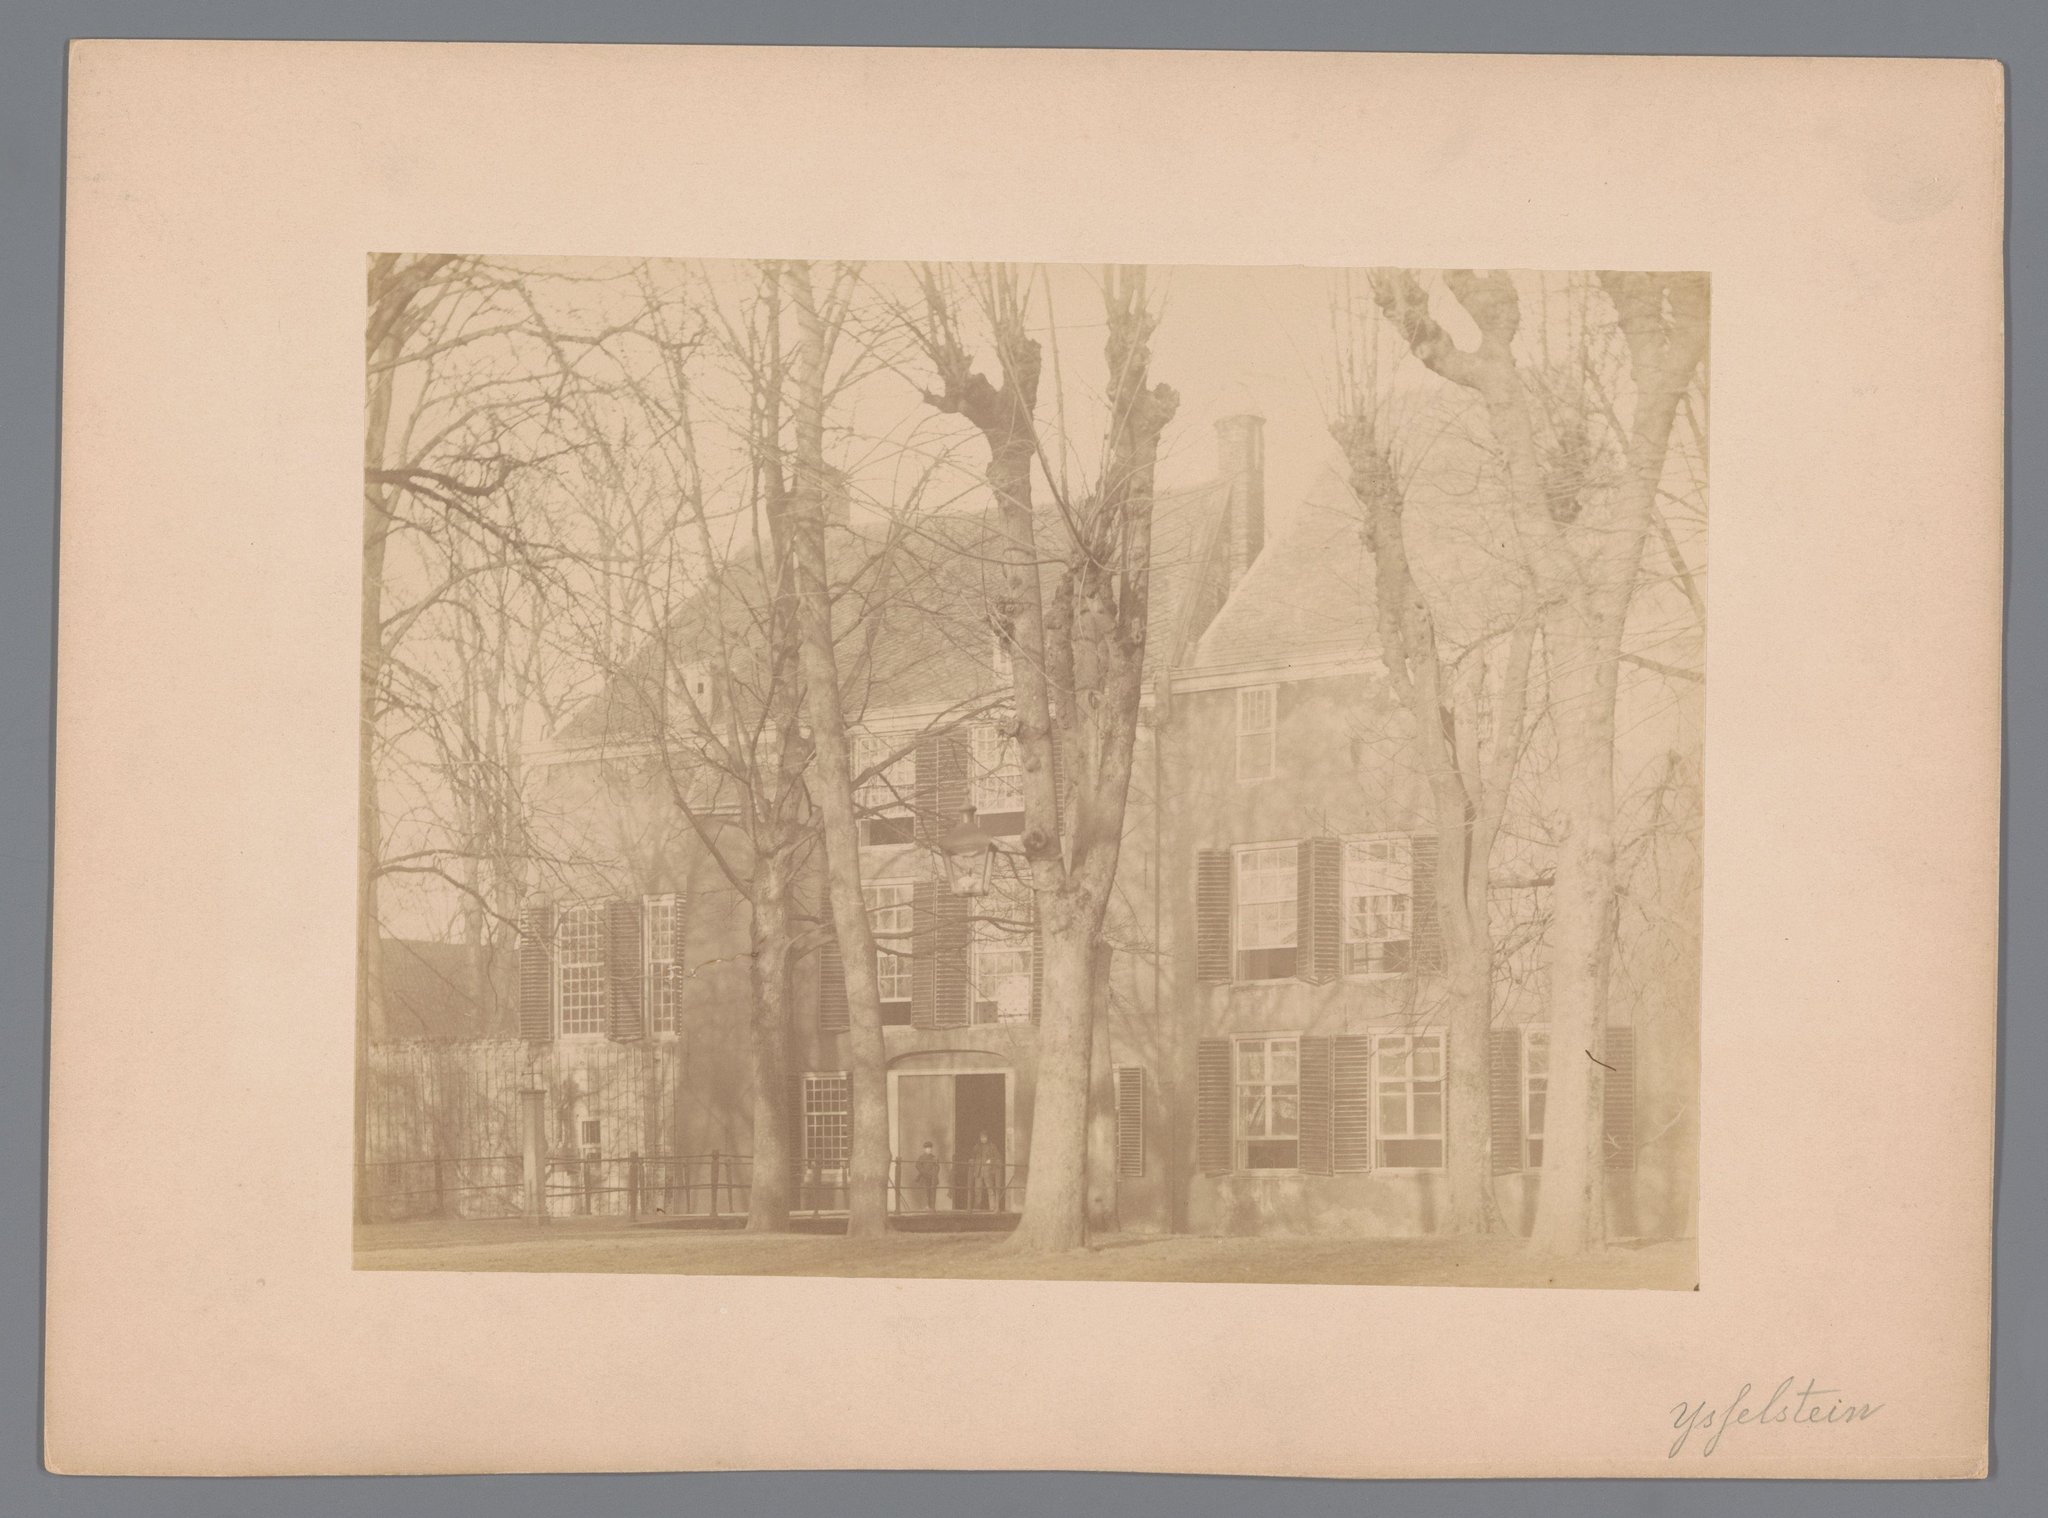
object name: photograph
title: Gezicht op Kasteel IJsselstein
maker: anoniem (monumentenzorg)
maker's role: fotograaf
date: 1888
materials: cardboard, photographic support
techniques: albumen print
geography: ijsselstein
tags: landscape with ruins (+ city(-scape) with figures, staffage), ruin of a dwelling, house, castle, etc.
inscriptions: annotation: ‘Kasteel te IJsselstein/ afgebroken 1888’, annotation: ‘IJsselstein’